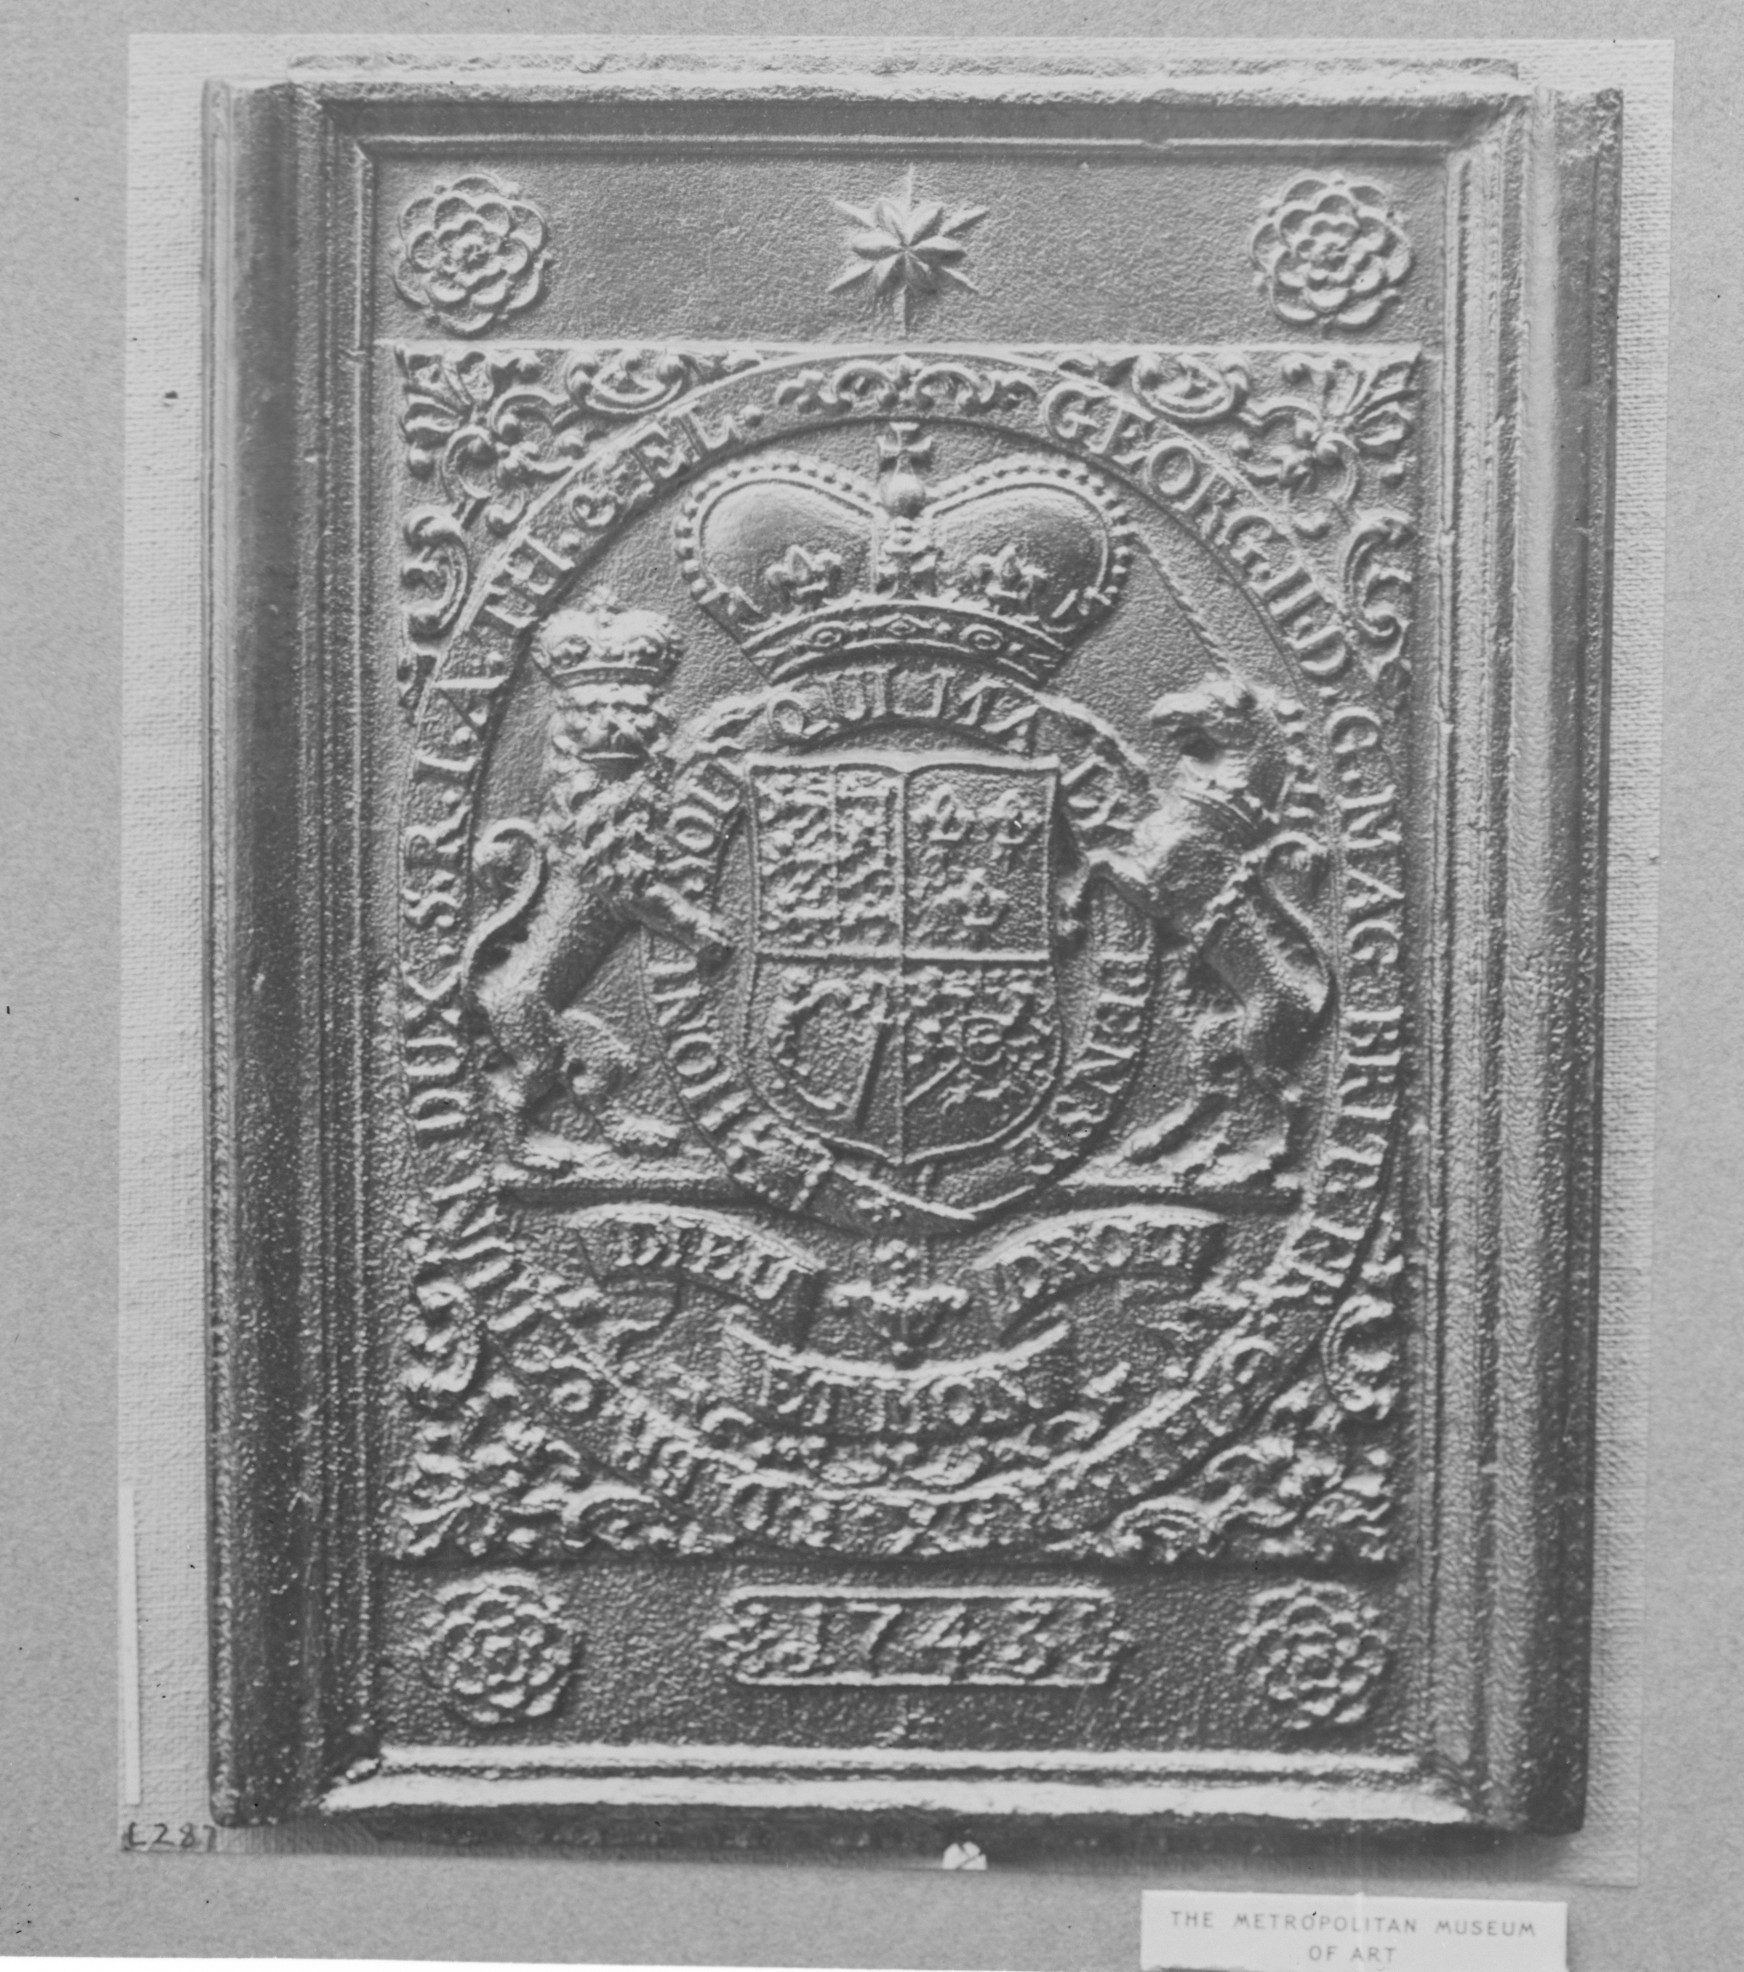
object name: stove plate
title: Stove plate with the royal arms of George II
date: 1743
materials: iron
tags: flowers,coat of arms